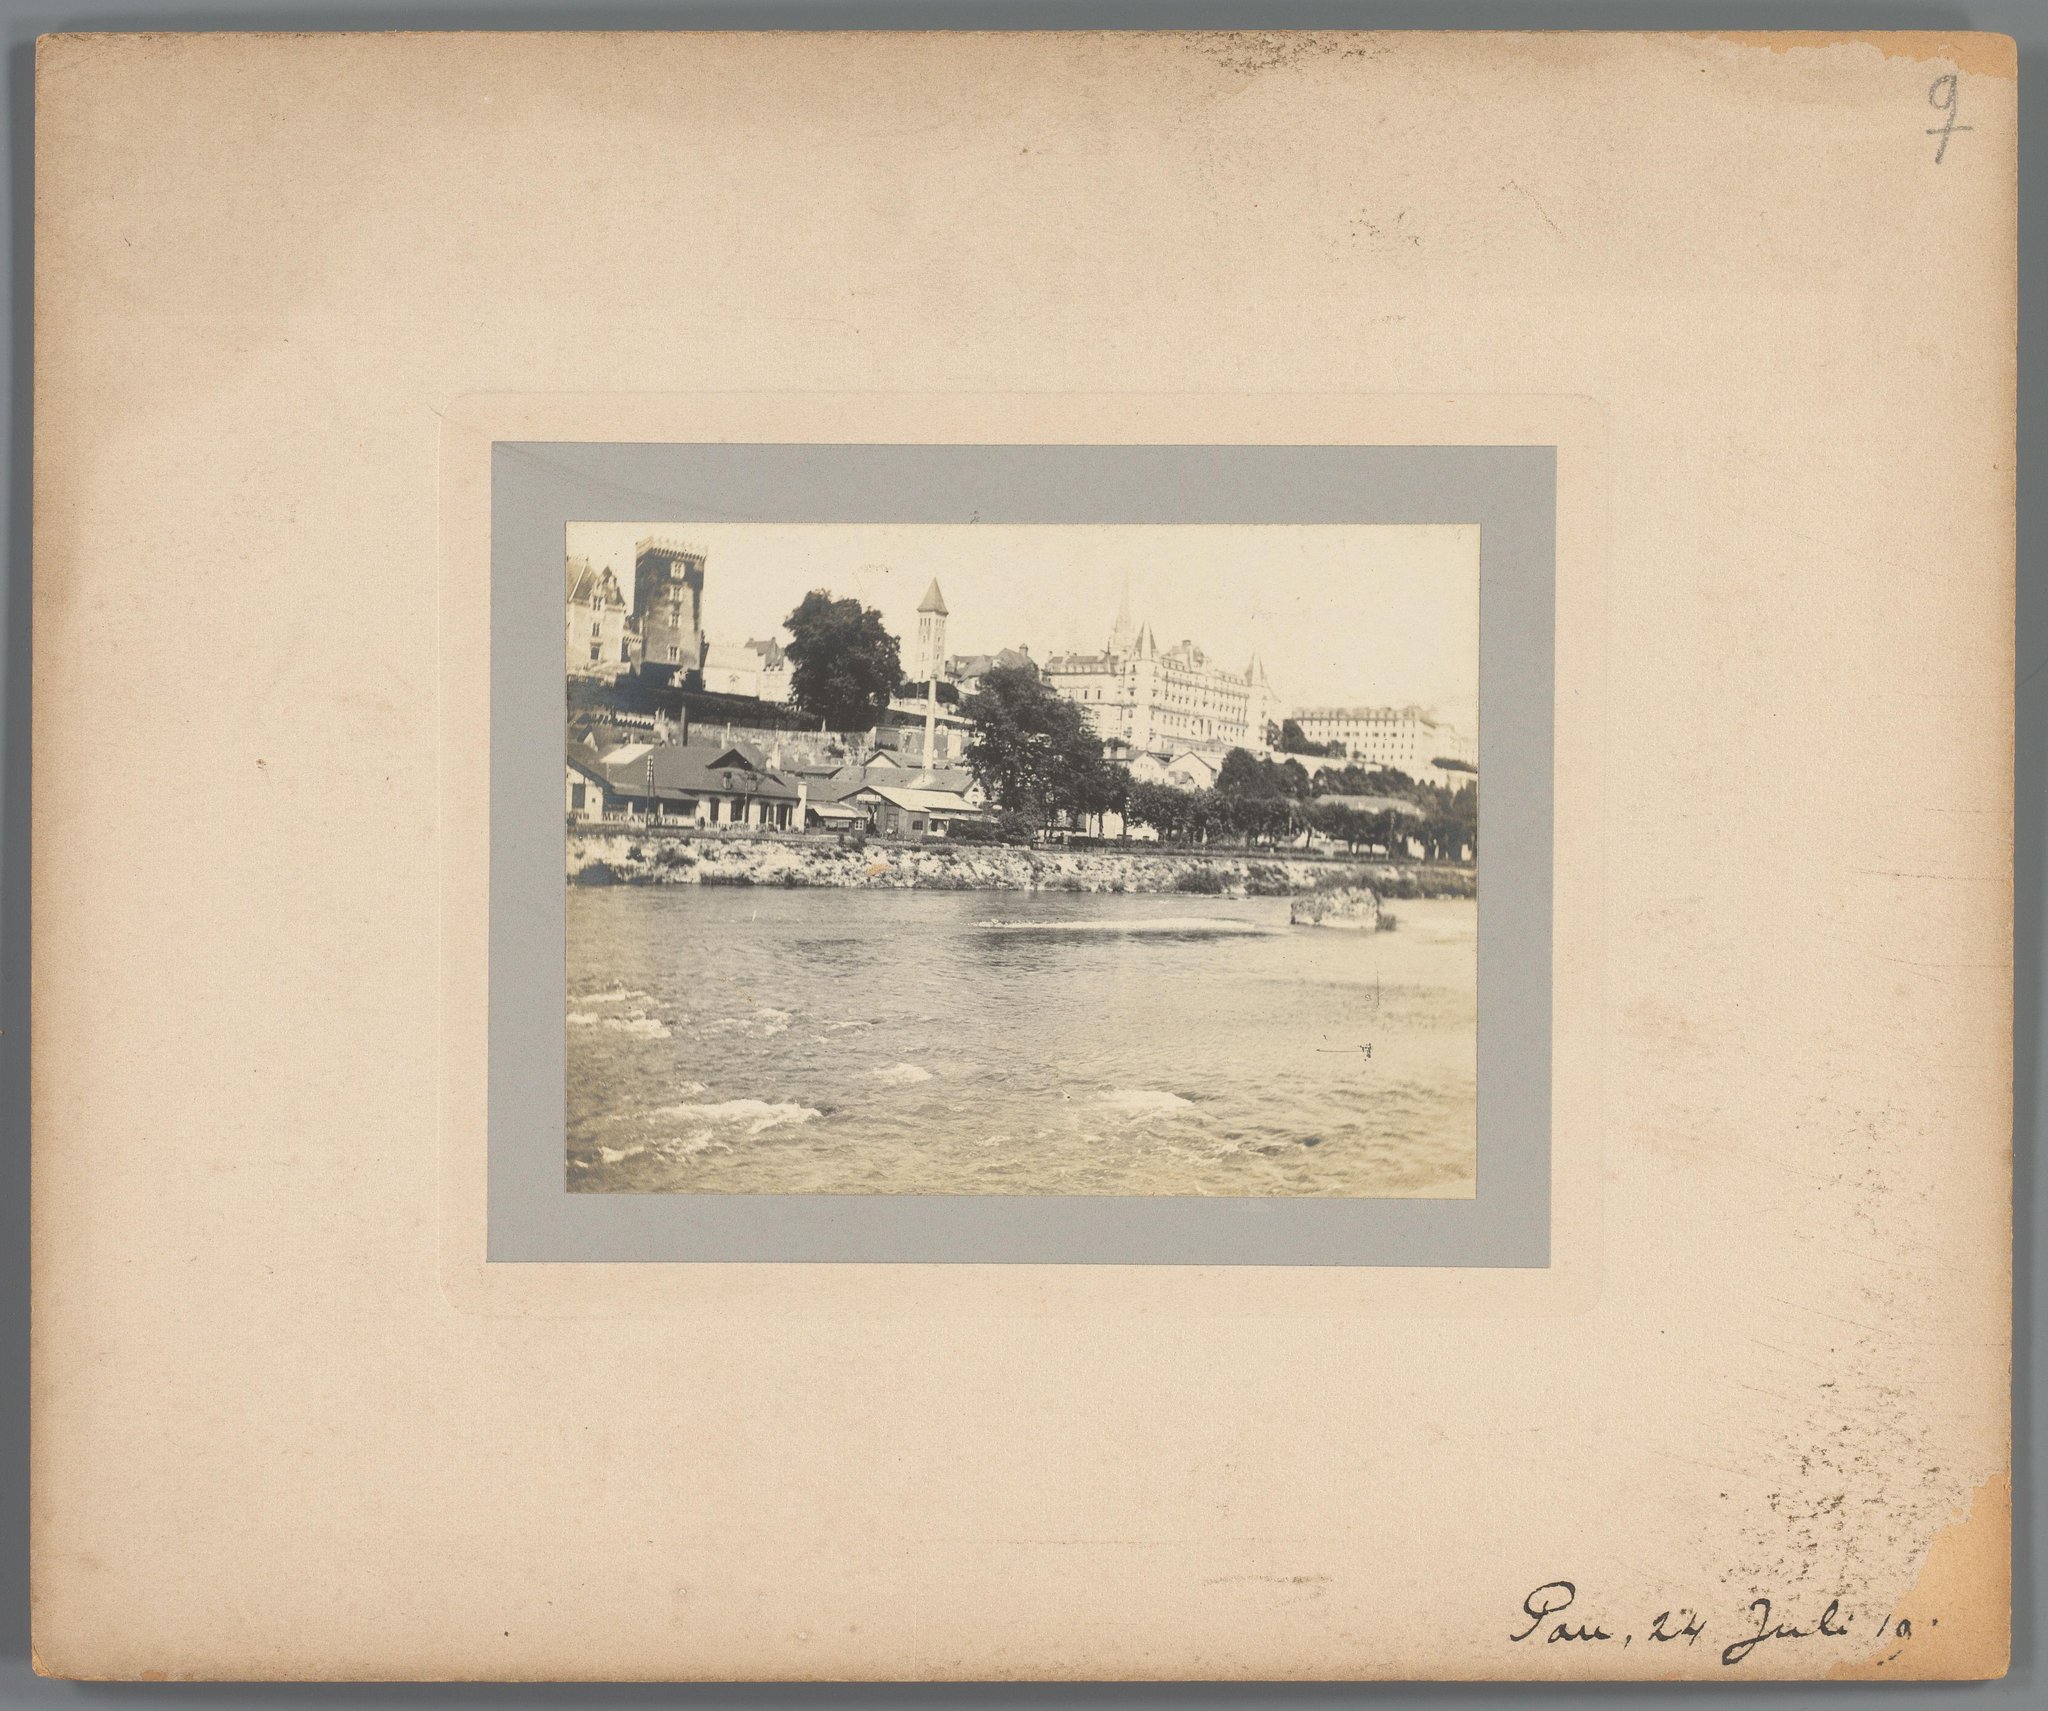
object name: photograph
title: Pau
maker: françois buys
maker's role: advocaat, amateurfotograaf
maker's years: 1871-1934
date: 1906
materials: paper, cardboard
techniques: gelatin silver print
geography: pau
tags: city-view in general; 'veduta', river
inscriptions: number: ‘9’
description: Deze foto maakt deel uit van een groep van 49 foto's.